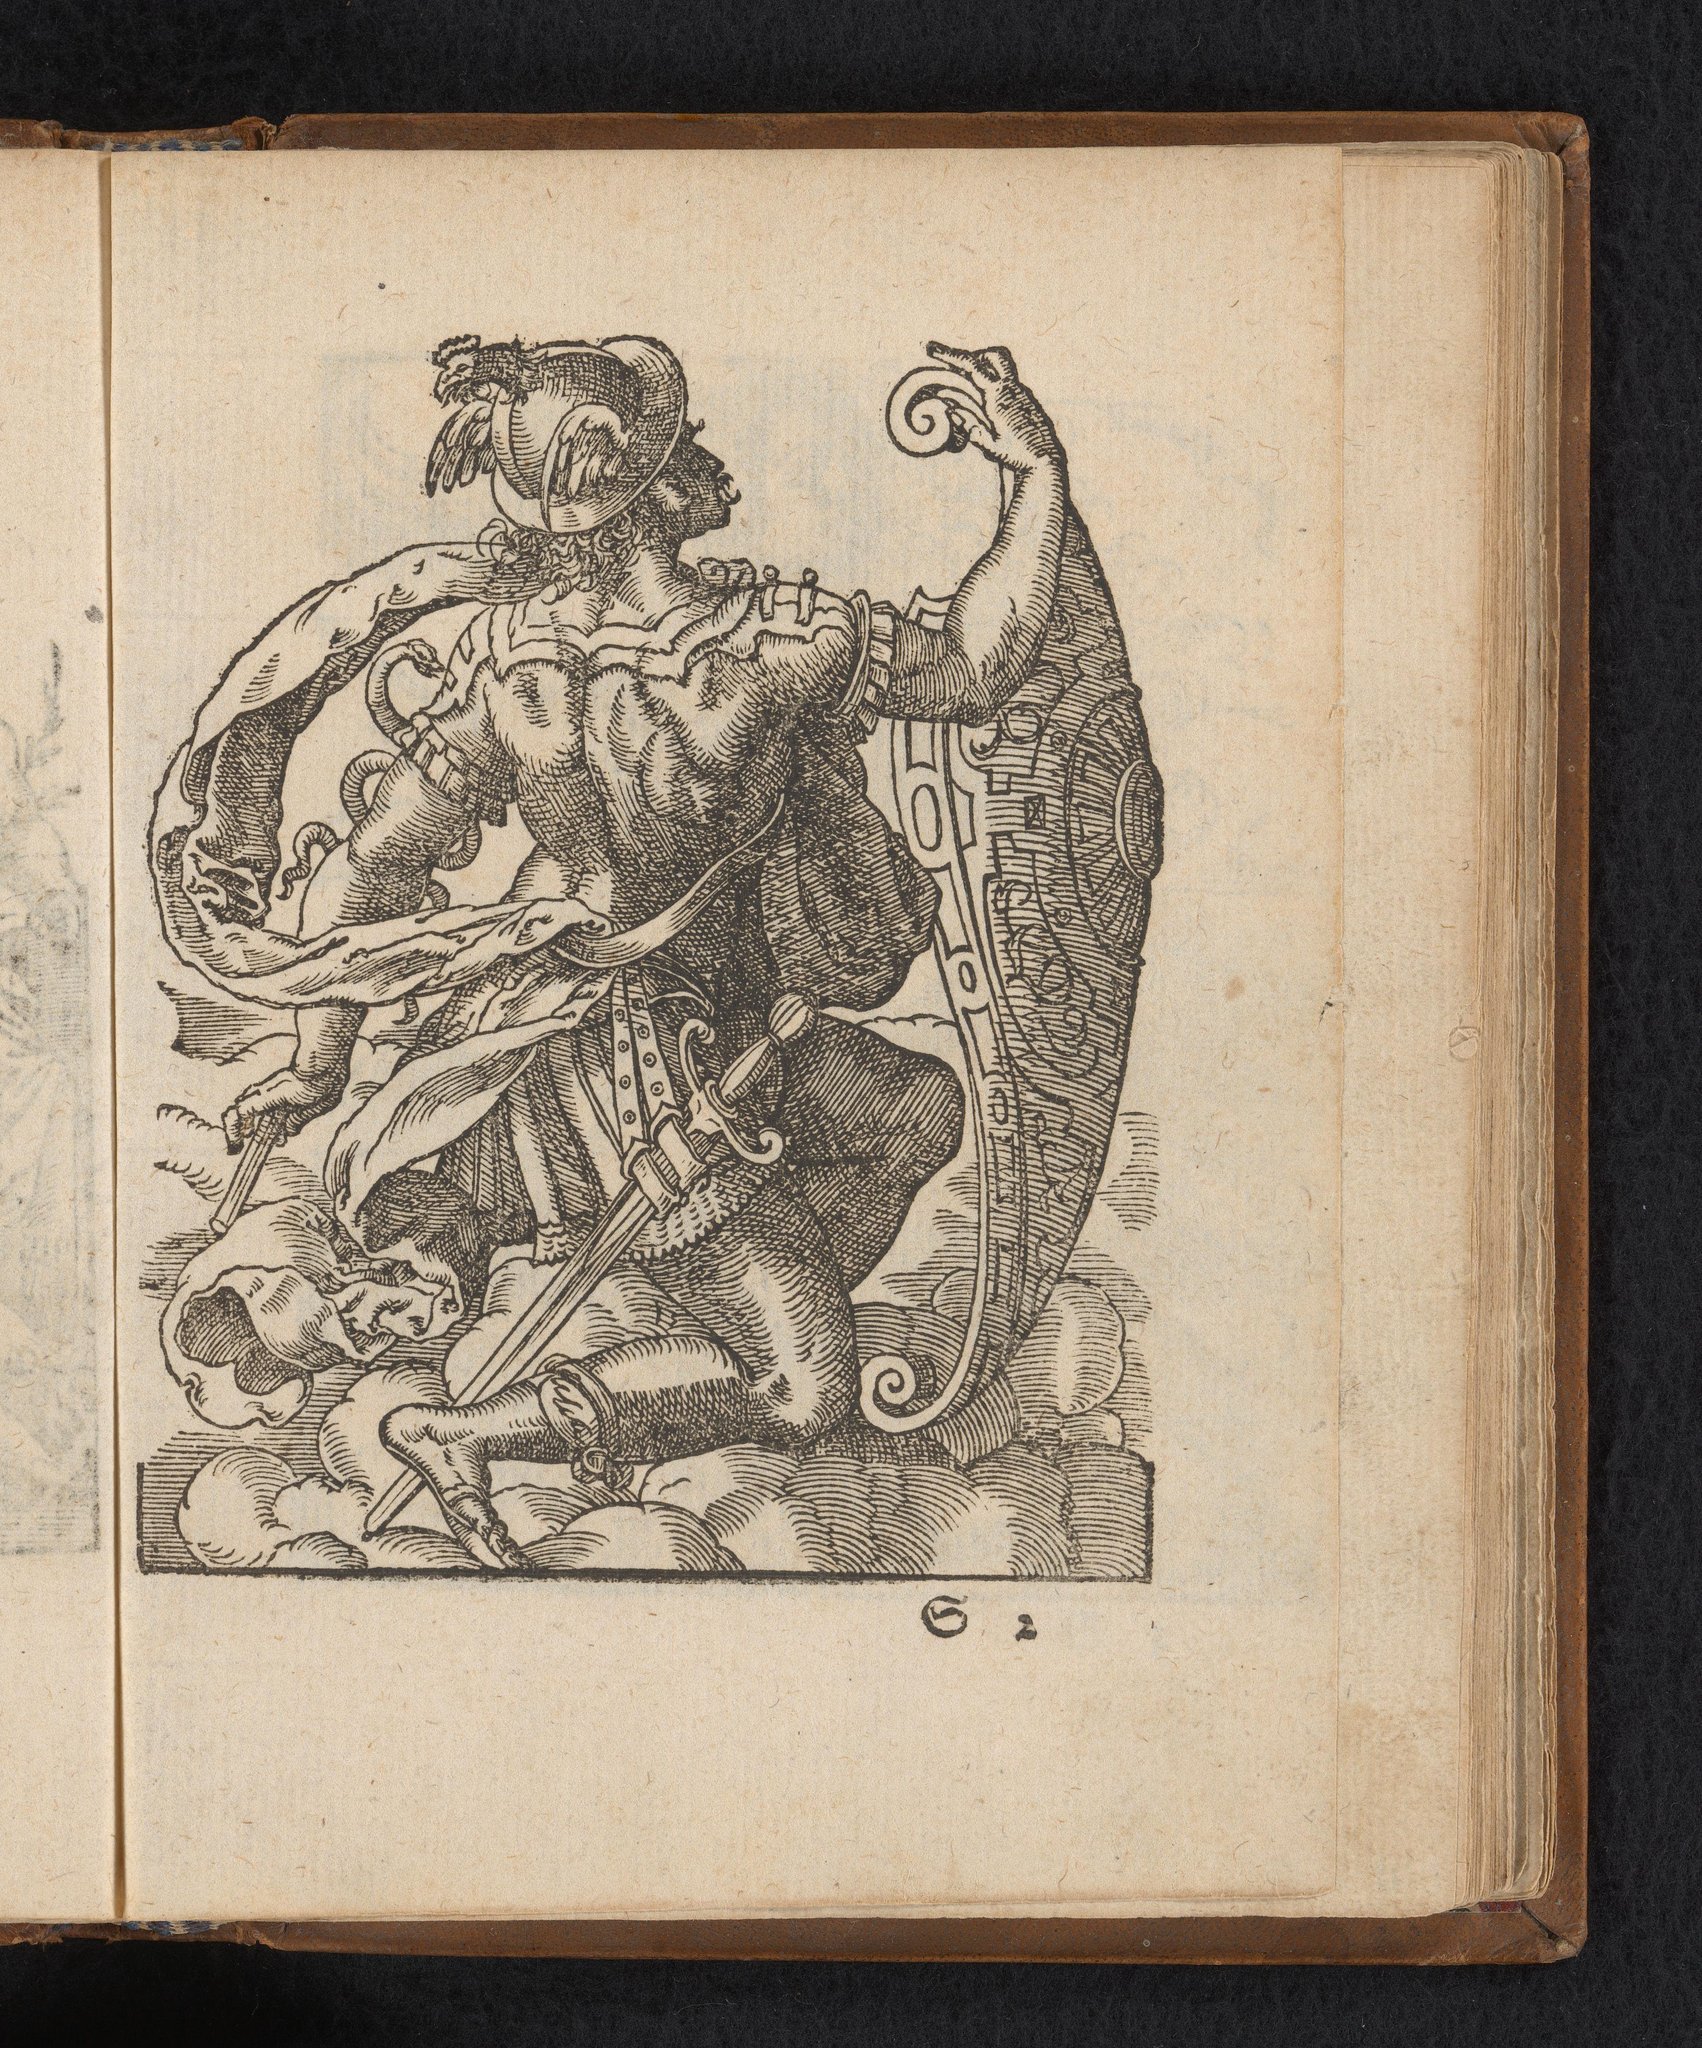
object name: print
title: Mercurius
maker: Anonymous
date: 1578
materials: paper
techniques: woodcut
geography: nuremberg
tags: (story of) mercury (hermes)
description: Mercurius, knielend met een groot schild, in de wolken. Onderdeel van het modelboek Enchiridion artis pingendi, fingendi & sculpendi met 108 figuren bedoeld voor beginnende schilders, beeldhouwers en prentmakers.